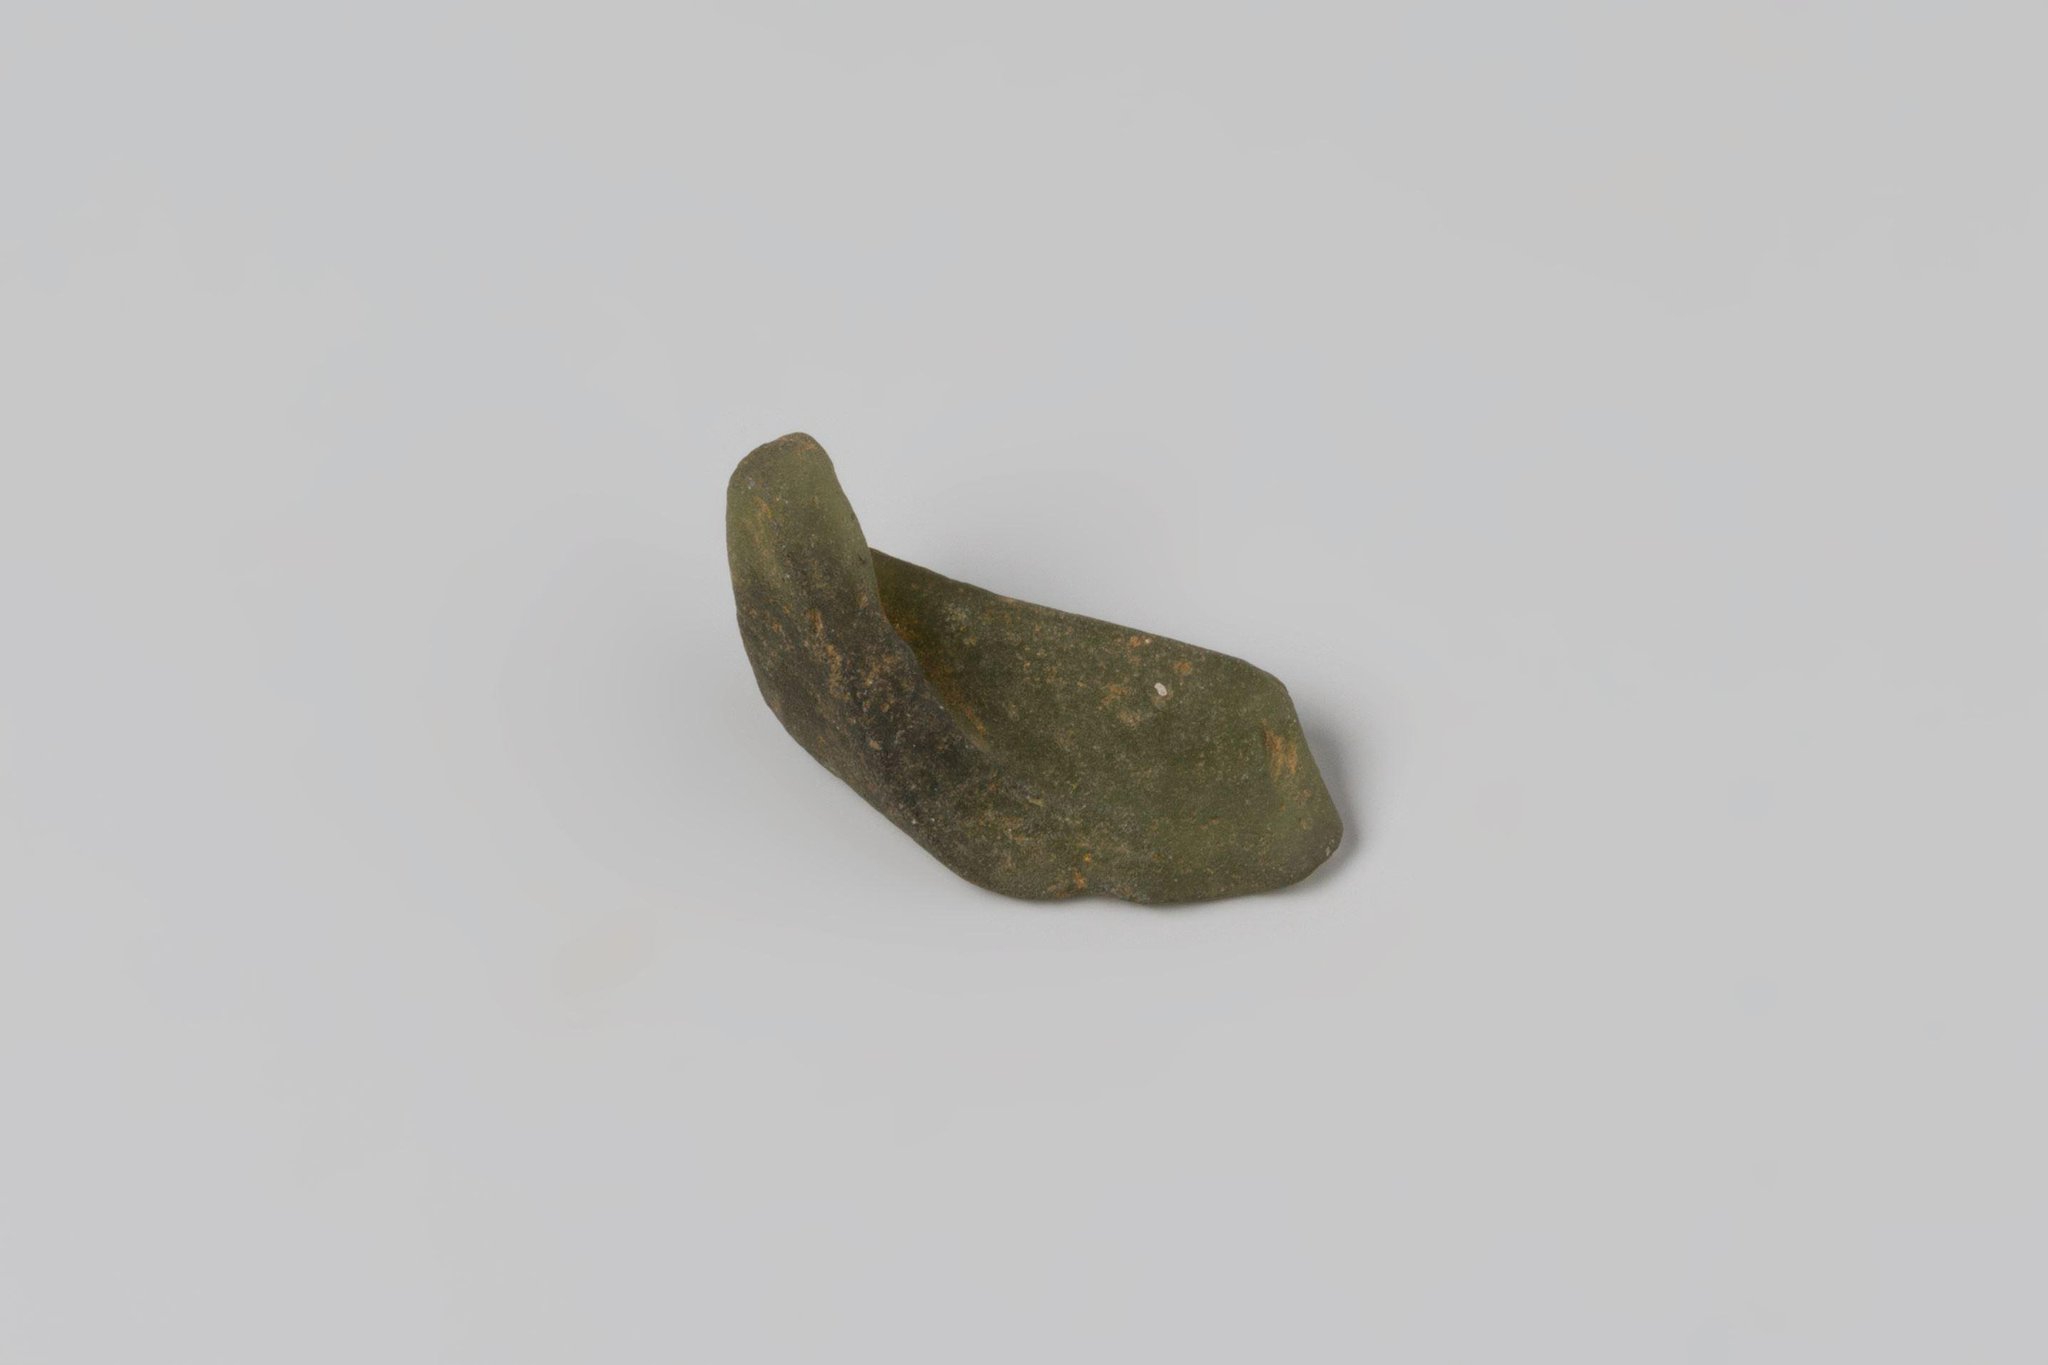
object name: sherd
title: Scherven van een kelderfles uit het wrak van de Oost-Indiëvaarder Hollandia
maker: Anonymous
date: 1700-1743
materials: glass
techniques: green glass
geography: netherlands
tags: verenigde oostindische compagnie, hollandia (schip), annet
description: Typologically not identifiable, base, fragm.